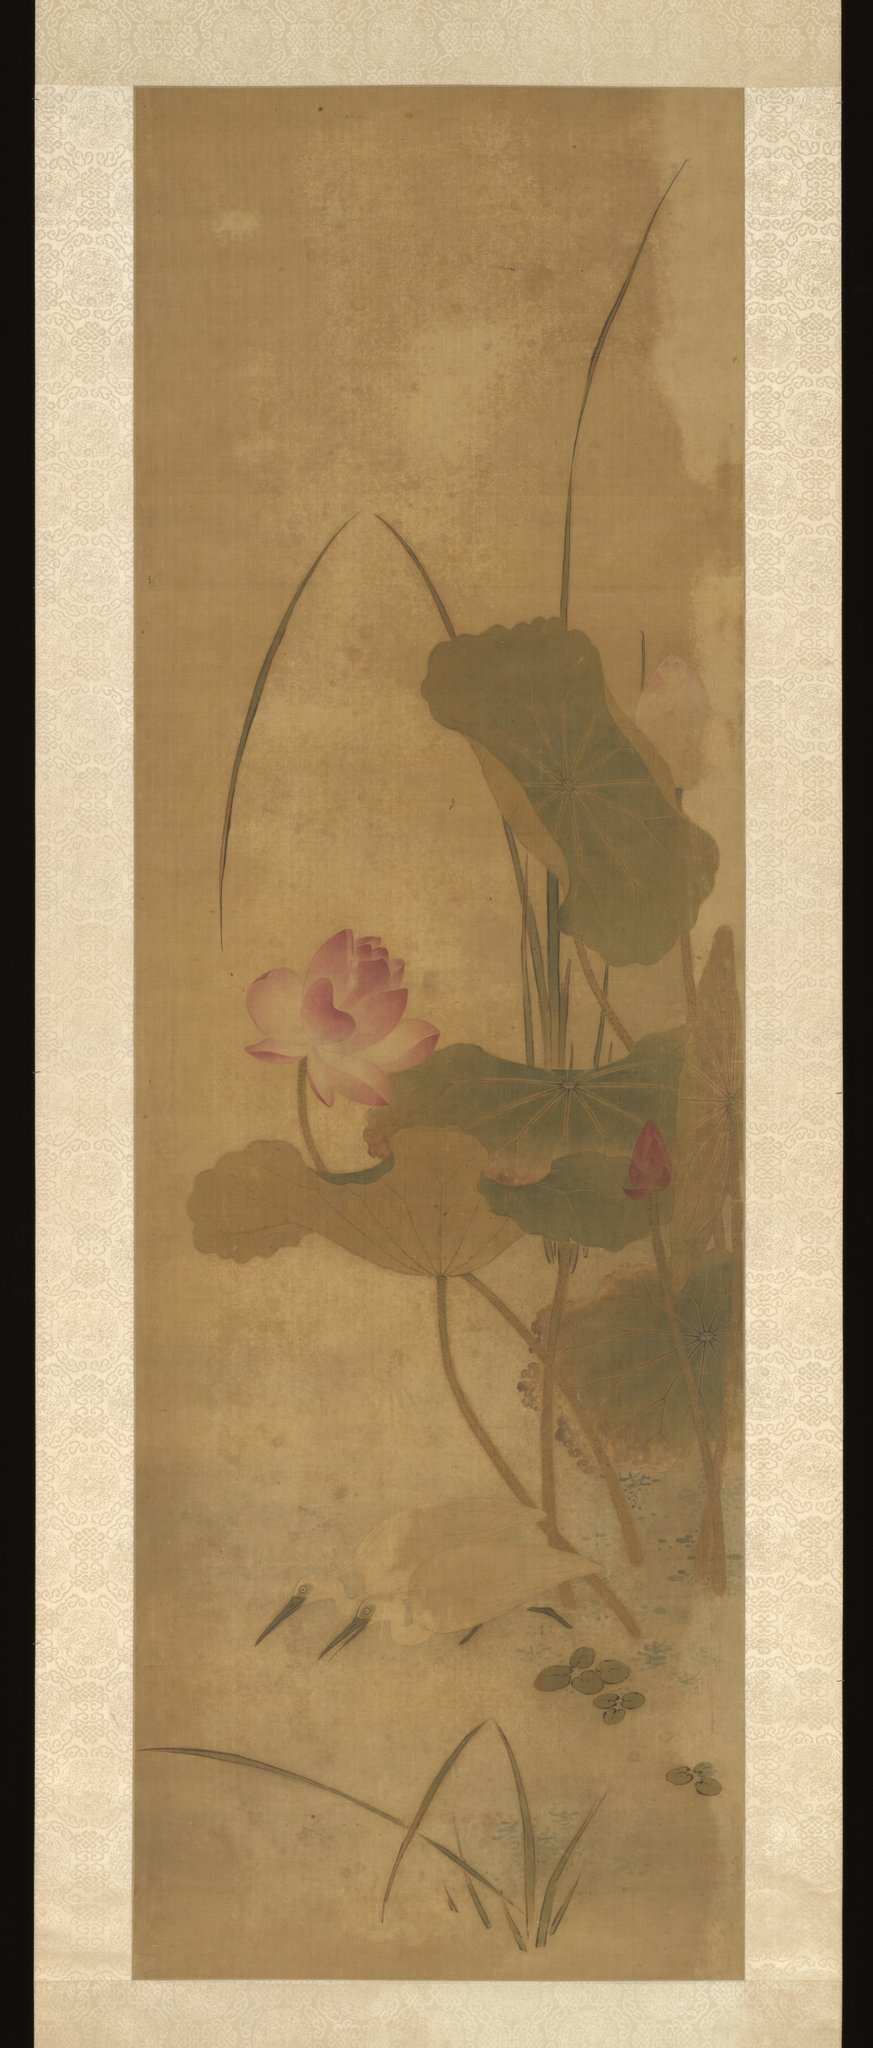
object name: hanging scroll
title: Herons in a Lotus Pond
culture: chinese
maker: unidentified artist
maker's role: artist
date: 1368-1911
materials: silk